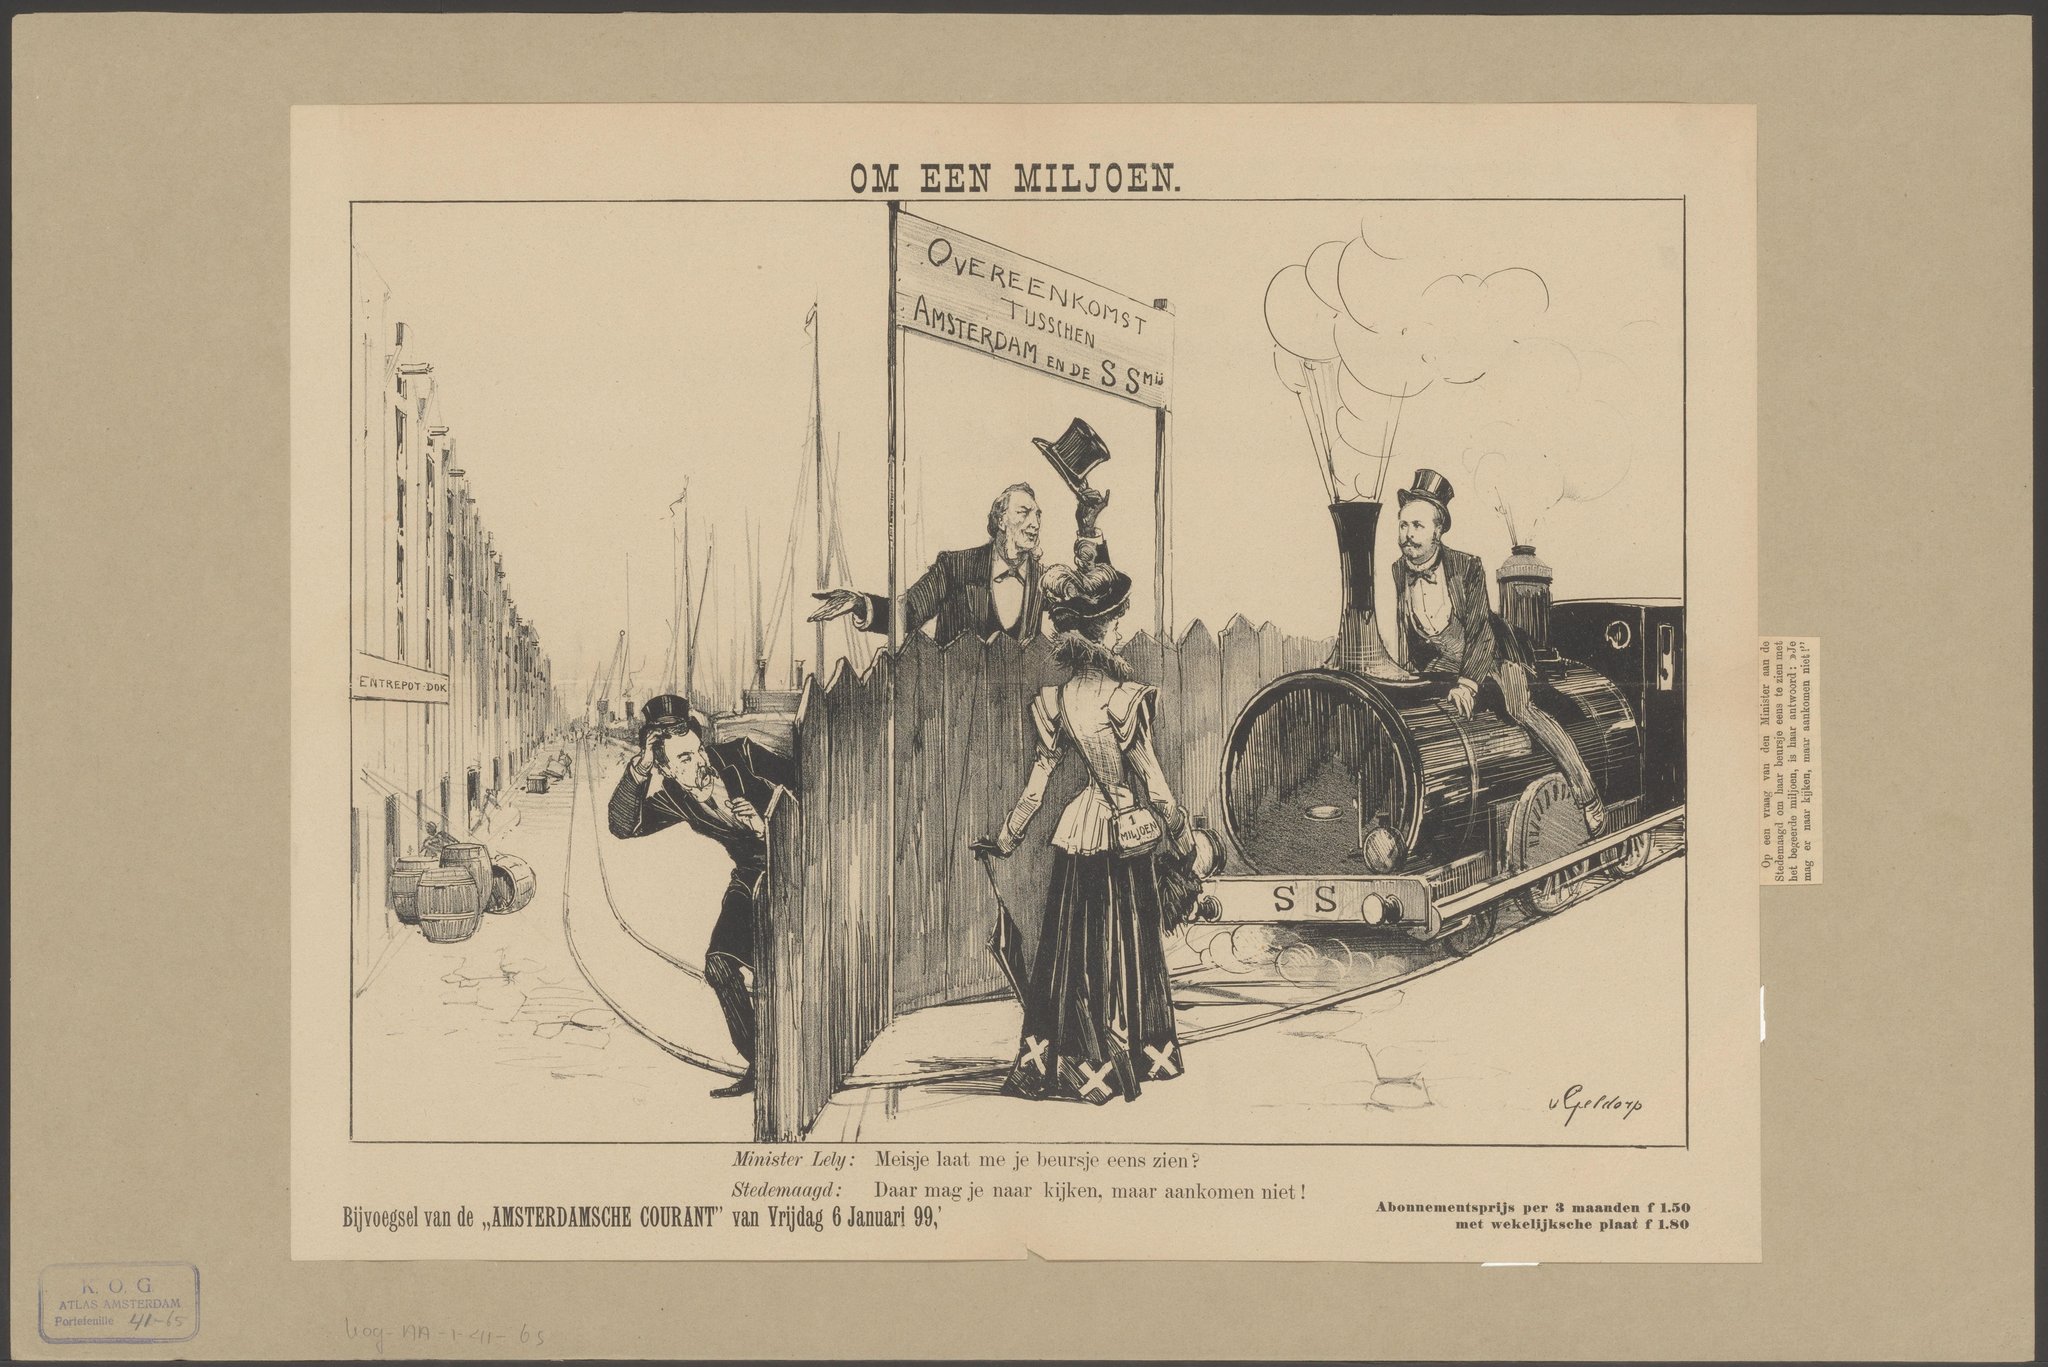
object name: photomechanical print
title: Drie mannen en de Stedenmaagd van Amsterdam bij het spoor door het Entrepotdok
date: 1899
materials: paper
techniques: letterpress printing, line block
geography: netherlands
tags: amsterdam, the hague, politician, harlingen, personification of a city, town-patron(ess), mayor, burgomaster, railway, train, steam locomotive, political caricatures and satires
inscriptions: collector's mark: ‘41-65’ Lugt 1641b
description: Minister Cornelis Lely komt rechts aan, zittend op een stoomlocomotief. Burgemeester Sjoerd Vening Meinesz gebaart vanachter een barricade op het spoor naar wethouder Johan Godfried Schölvinck, die zich schuilhoudt; de stedenmaagd van Amsterdam kijkt toe. Onderwerpsrubriek binnen de Atlas Amsterdam: Entrepot.